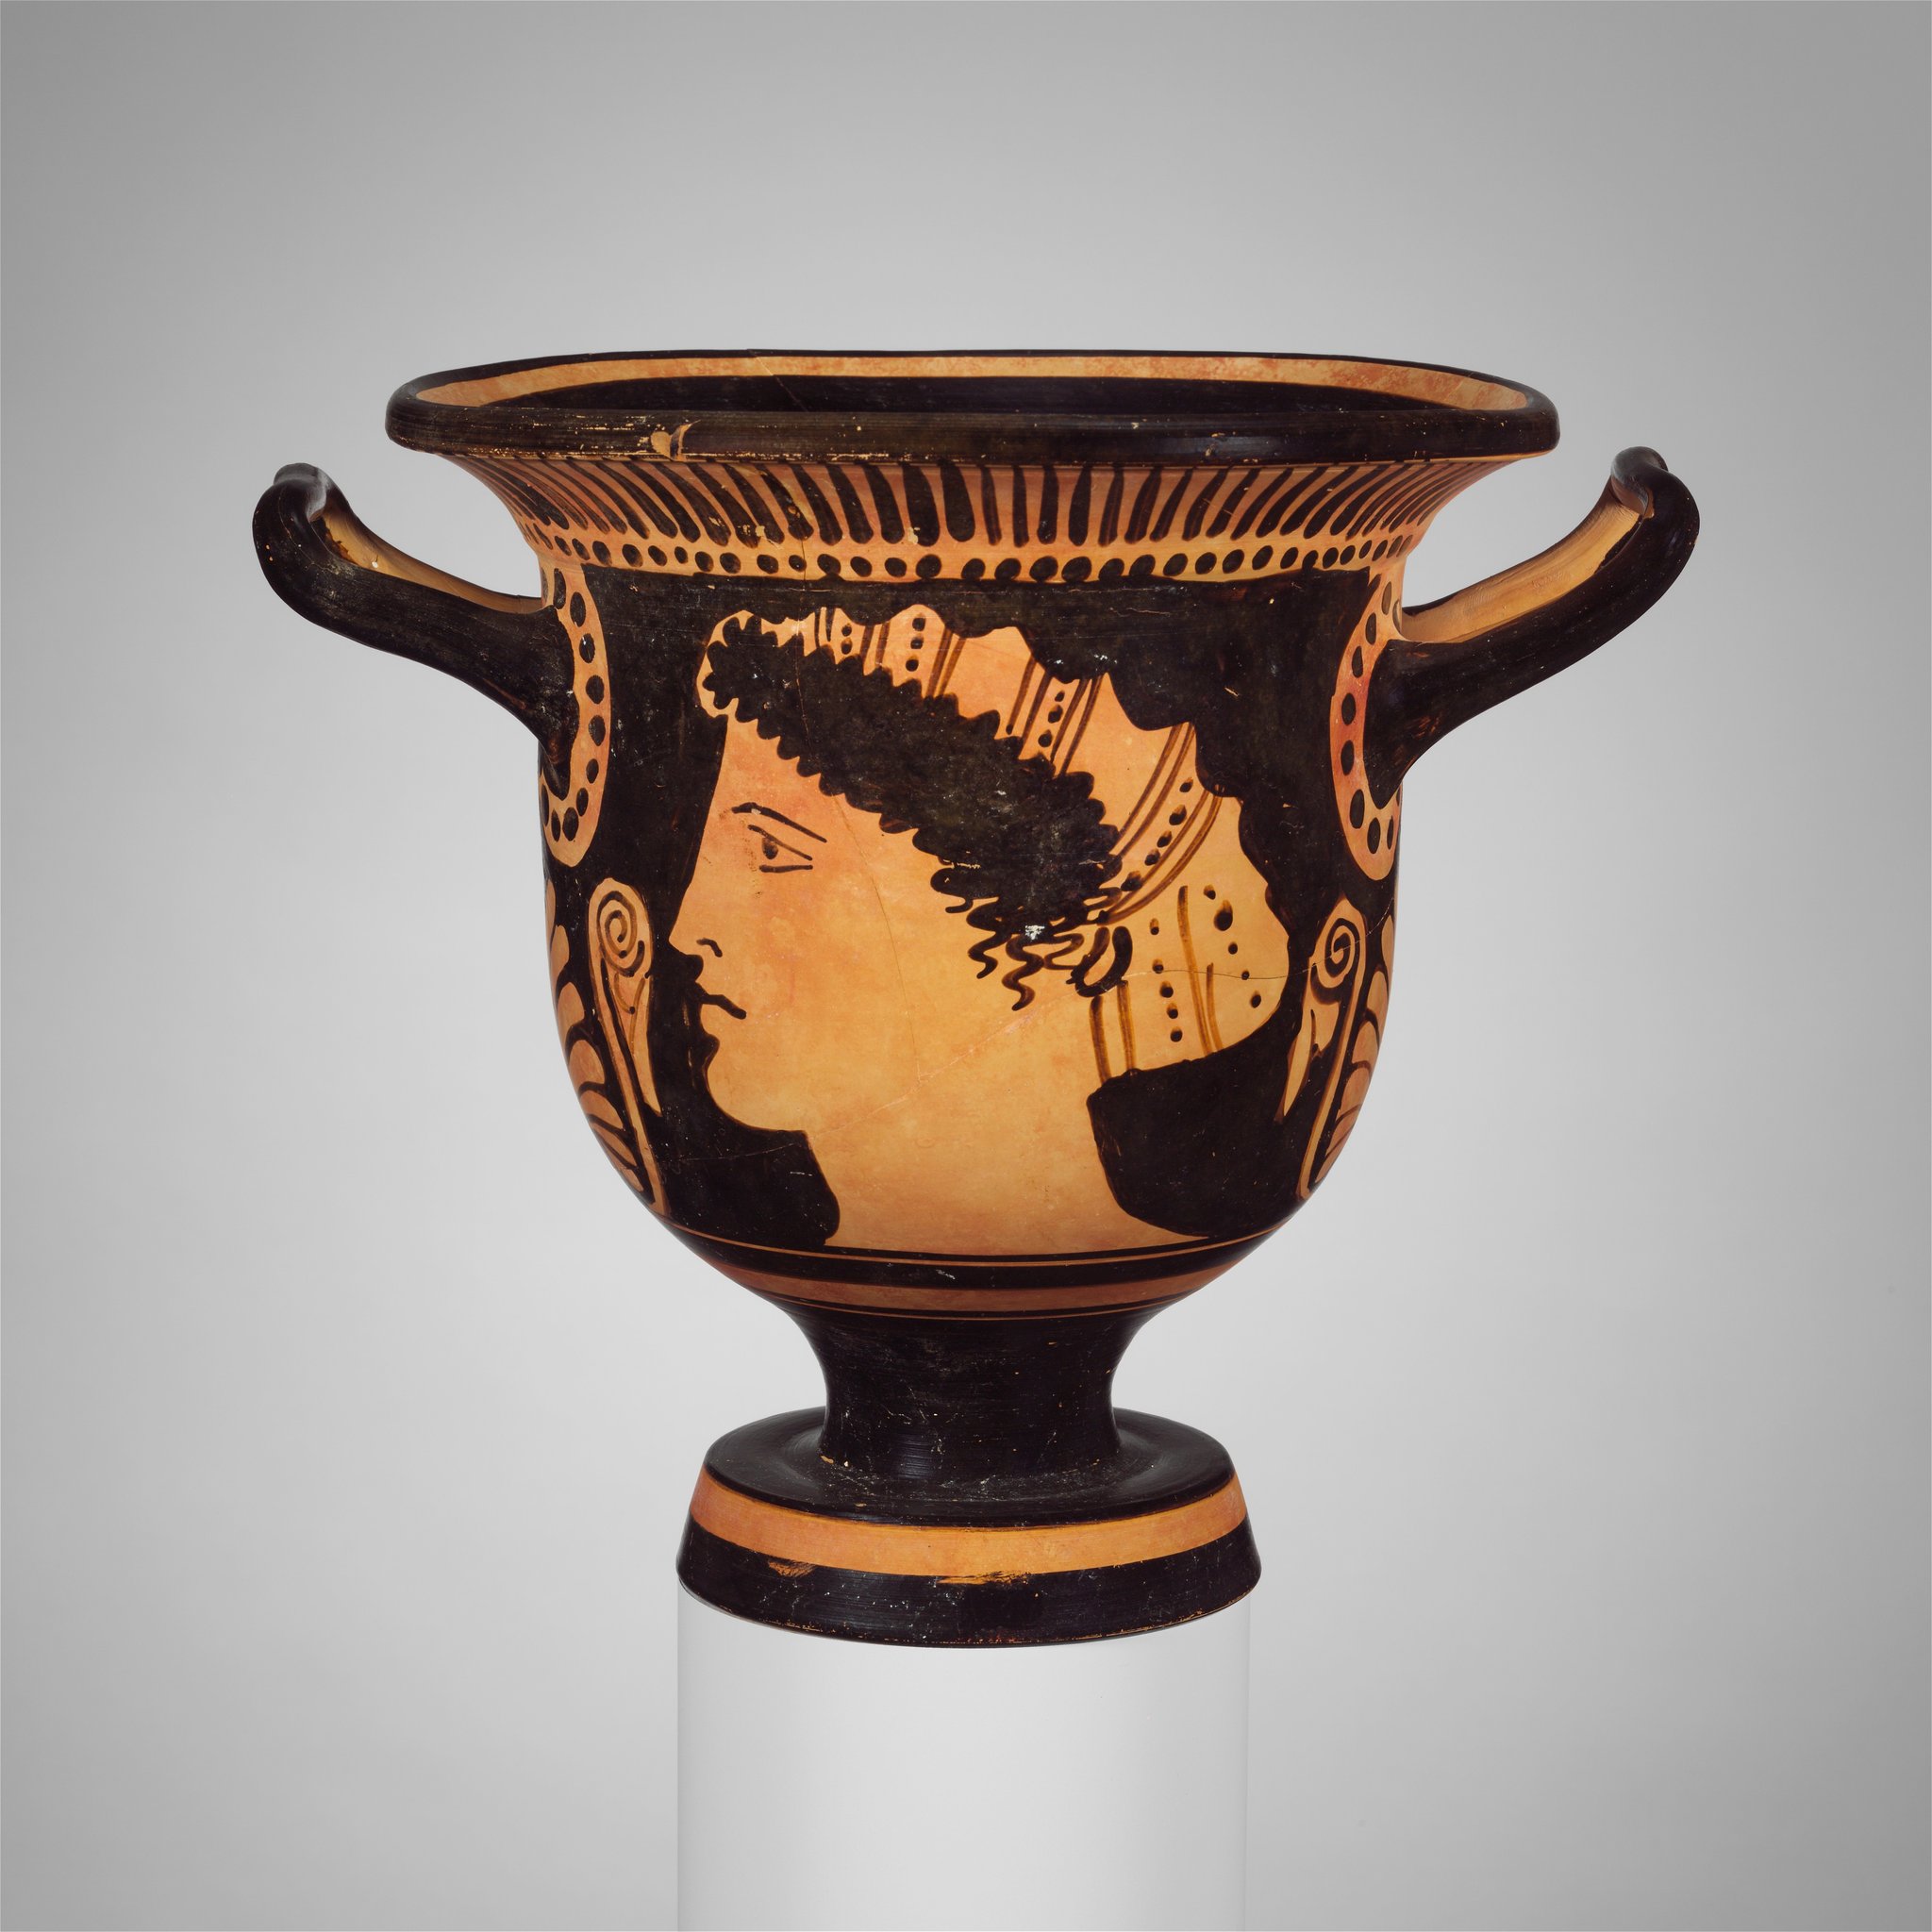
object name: bell krater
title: Terracotta bell-krater (bowl for mixing wine and water)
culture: greek, boeotian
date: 434-401 BCE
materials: terracotta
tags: women